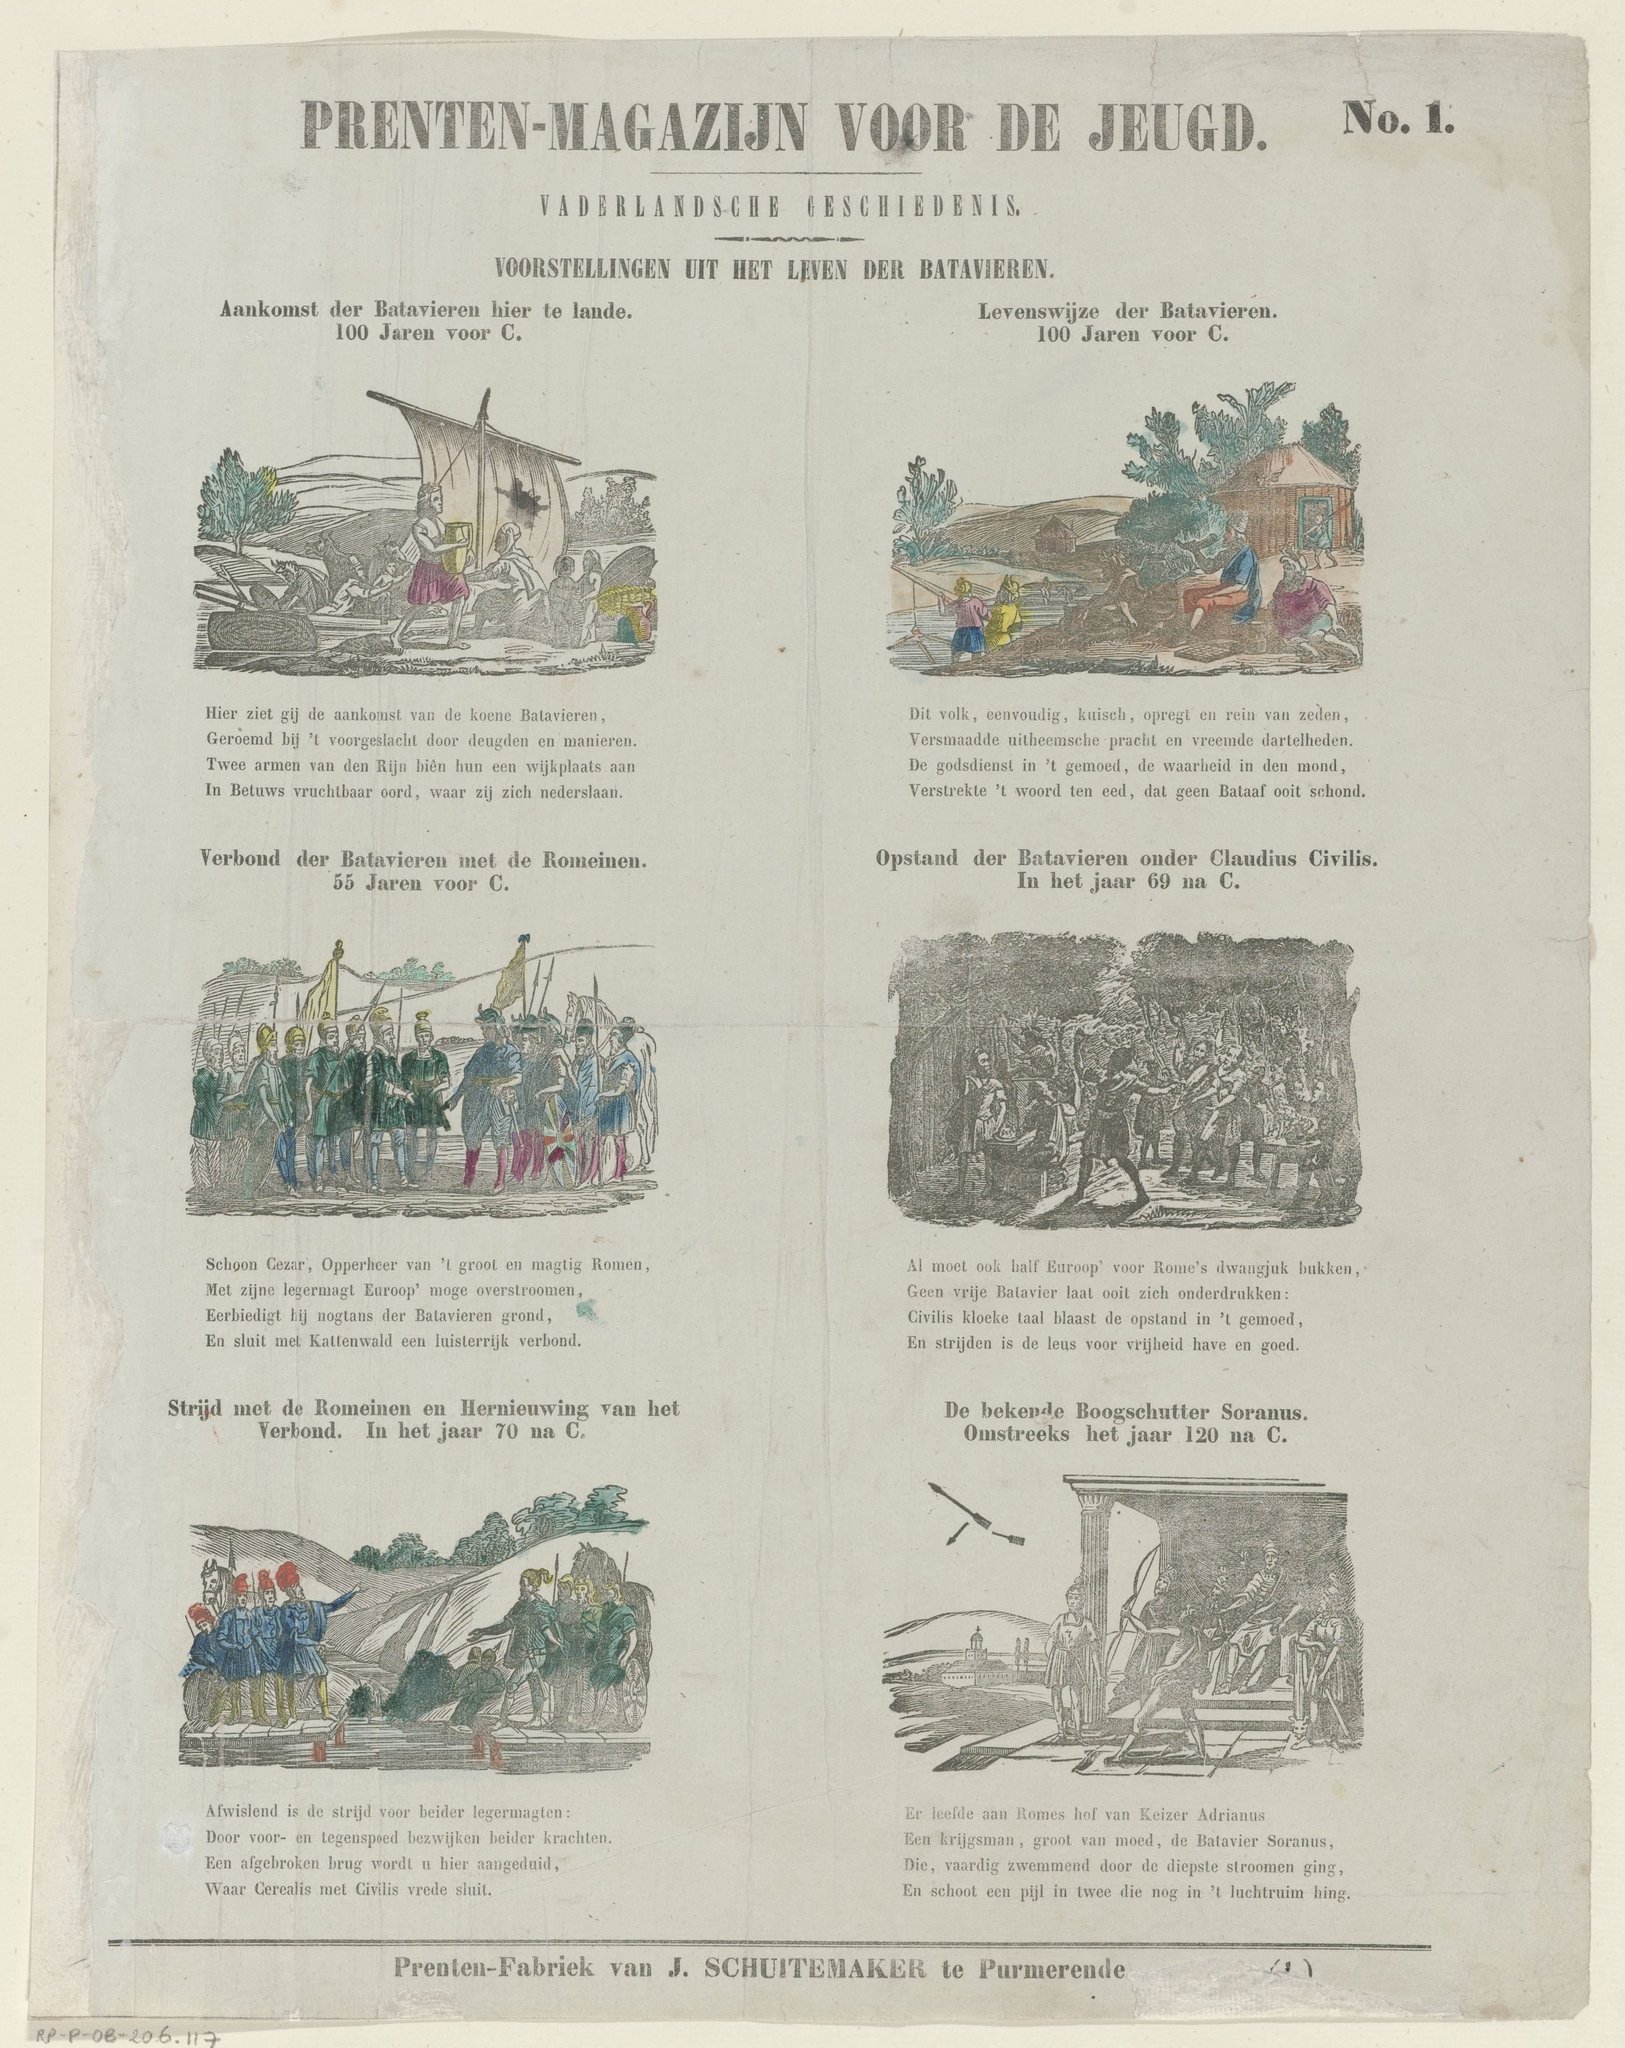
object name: print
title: Voorstellingen uit het leven der Batavieren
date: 1850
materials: paper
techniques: colour, letterpress printing, engraving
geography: netherlands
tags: the soldier; the soldier's life, shooting with bow and arrow, archery (~ games of skill)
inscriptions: collector's mark: Lugt 2760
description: Na voltooiing van de acht jaargangen van de reeks 'Prenten-magazijn voor de jeugd' in 1850 heeft Jan Schuitemaker al deze prenten heruitgegeven en omgenummerd als nr. 1 t/m 192. De oorspronkelijke jaargang wordt telkens nog vermeld rechtsonder op de prent. Binnen de jaargangen zijn prenten van hetzelfde thema in clusters van vier achter elkaar gezet.